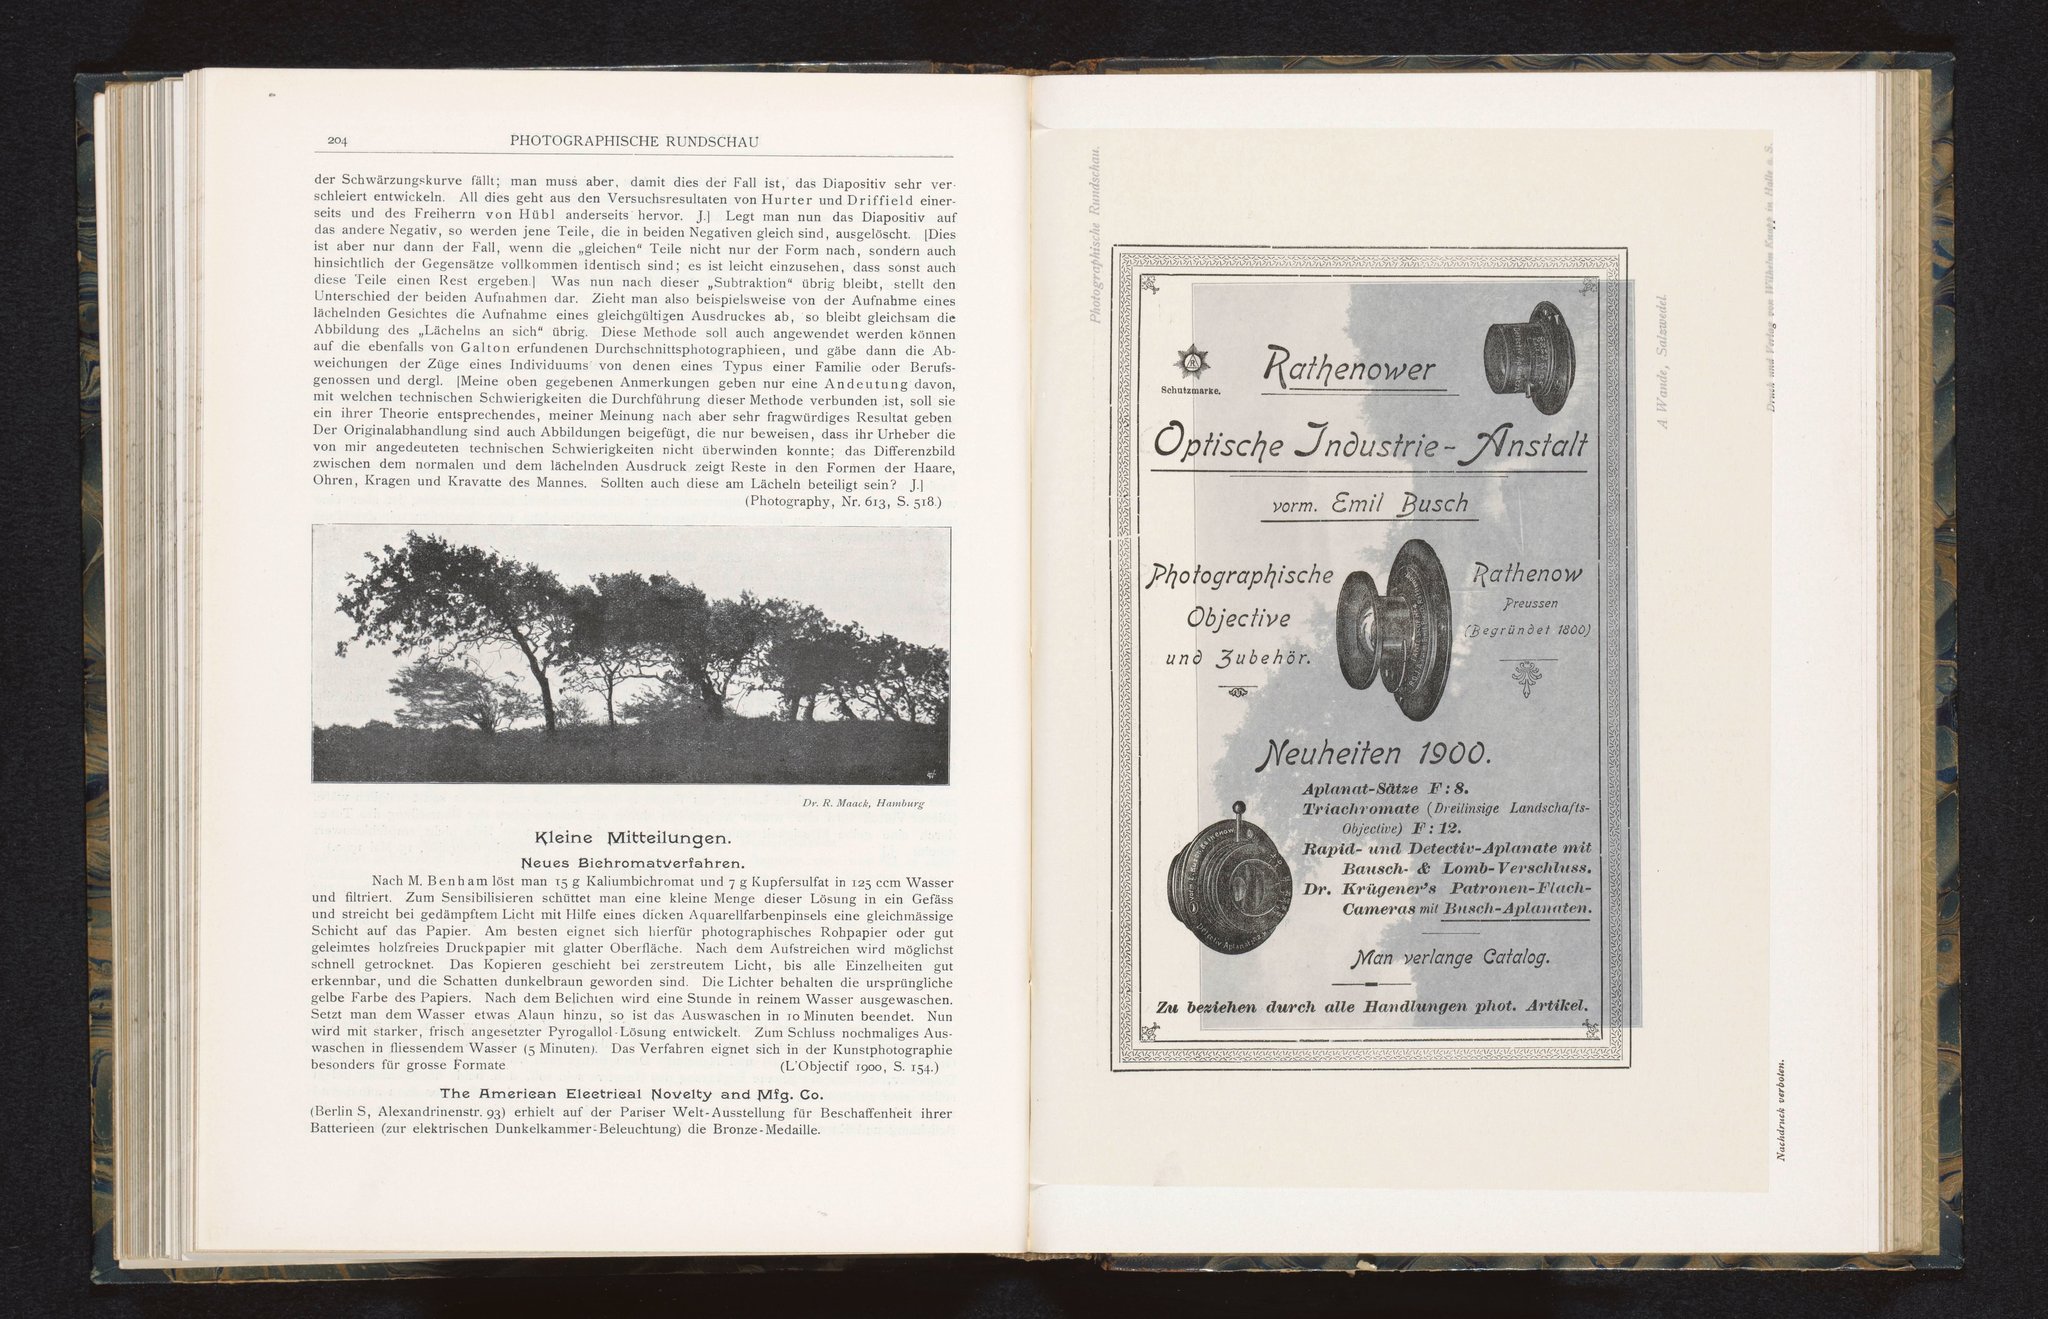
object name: page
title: Gezicht op een aantal bomen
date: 1895-1900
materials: paper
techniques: autotype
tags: trees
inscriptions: monogram: ‘WC’